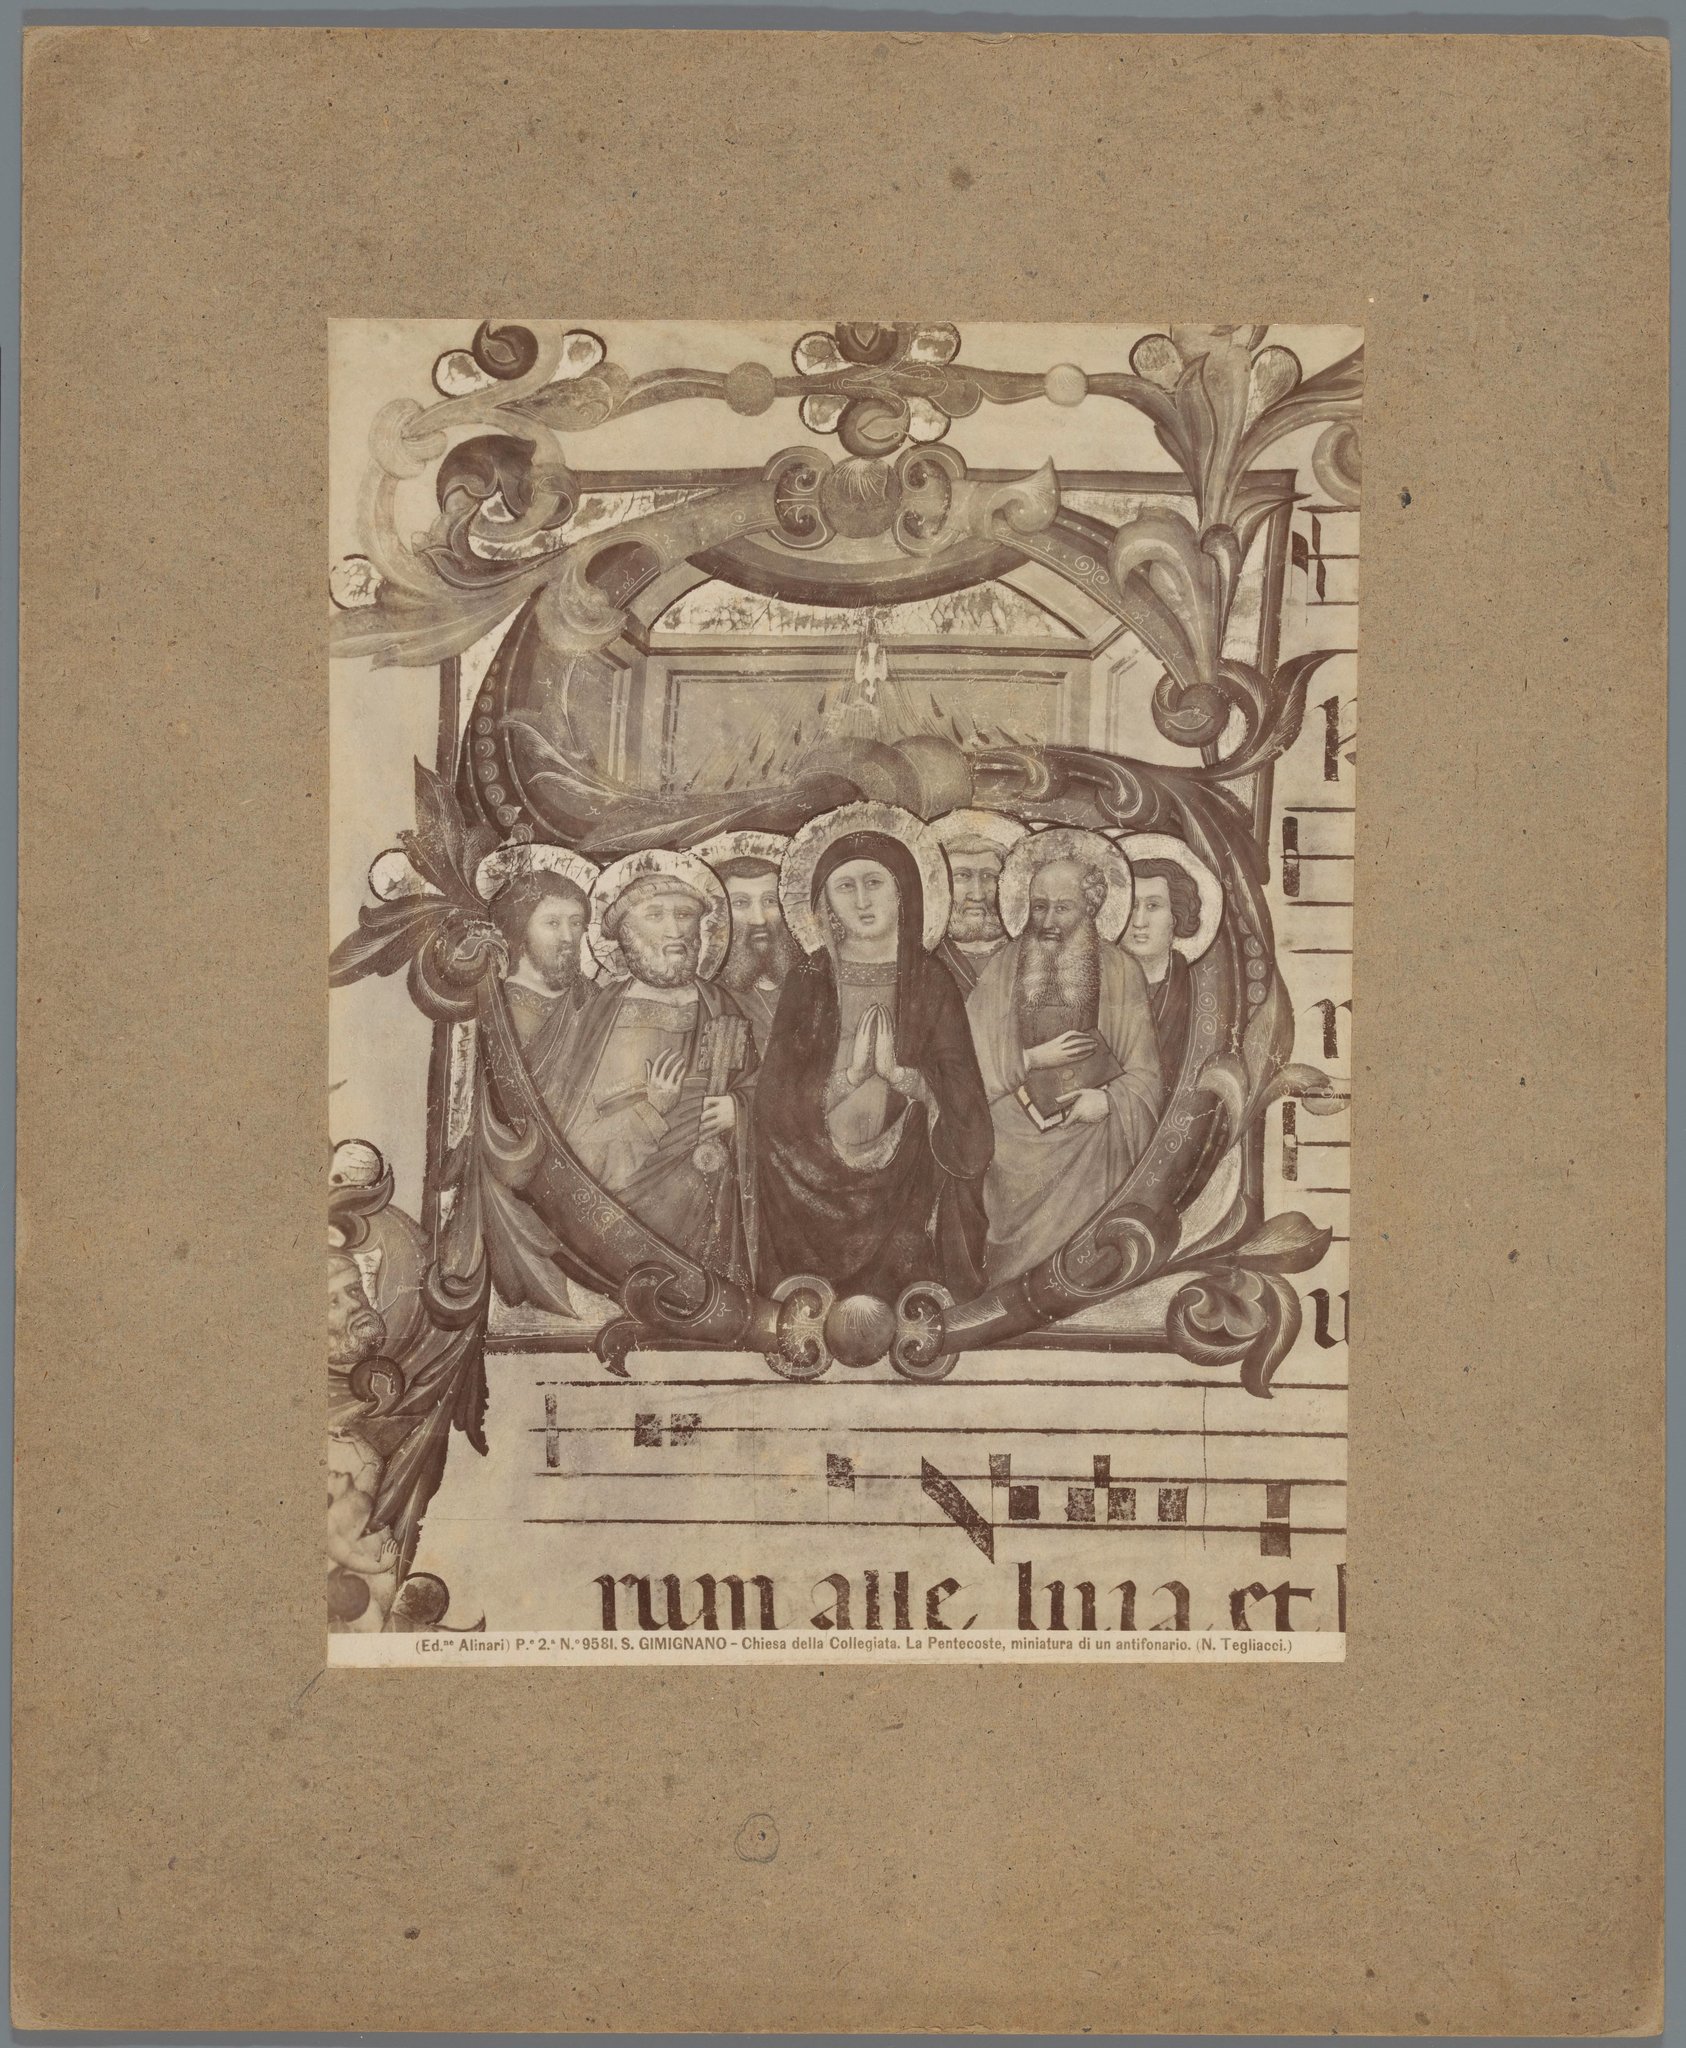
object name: photograph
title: S. GIMIGNANO - Chiesa della Collegiata. La Pentecoste, miniatura di un antifonario.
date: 1875-1900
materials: cardboard, photographic support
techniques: albumen print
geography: collegiata santa maria assunta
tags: painting (including book-illumination, miniature-painting), pentecost: the holy ghost descends upon (mary and) the apostles, sometimes paul and/or representatives of the nations present (acts 2:1-4)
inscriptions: collector's mark: Lugt 3937, number: ‘P.e 2.a N.o 9581.’